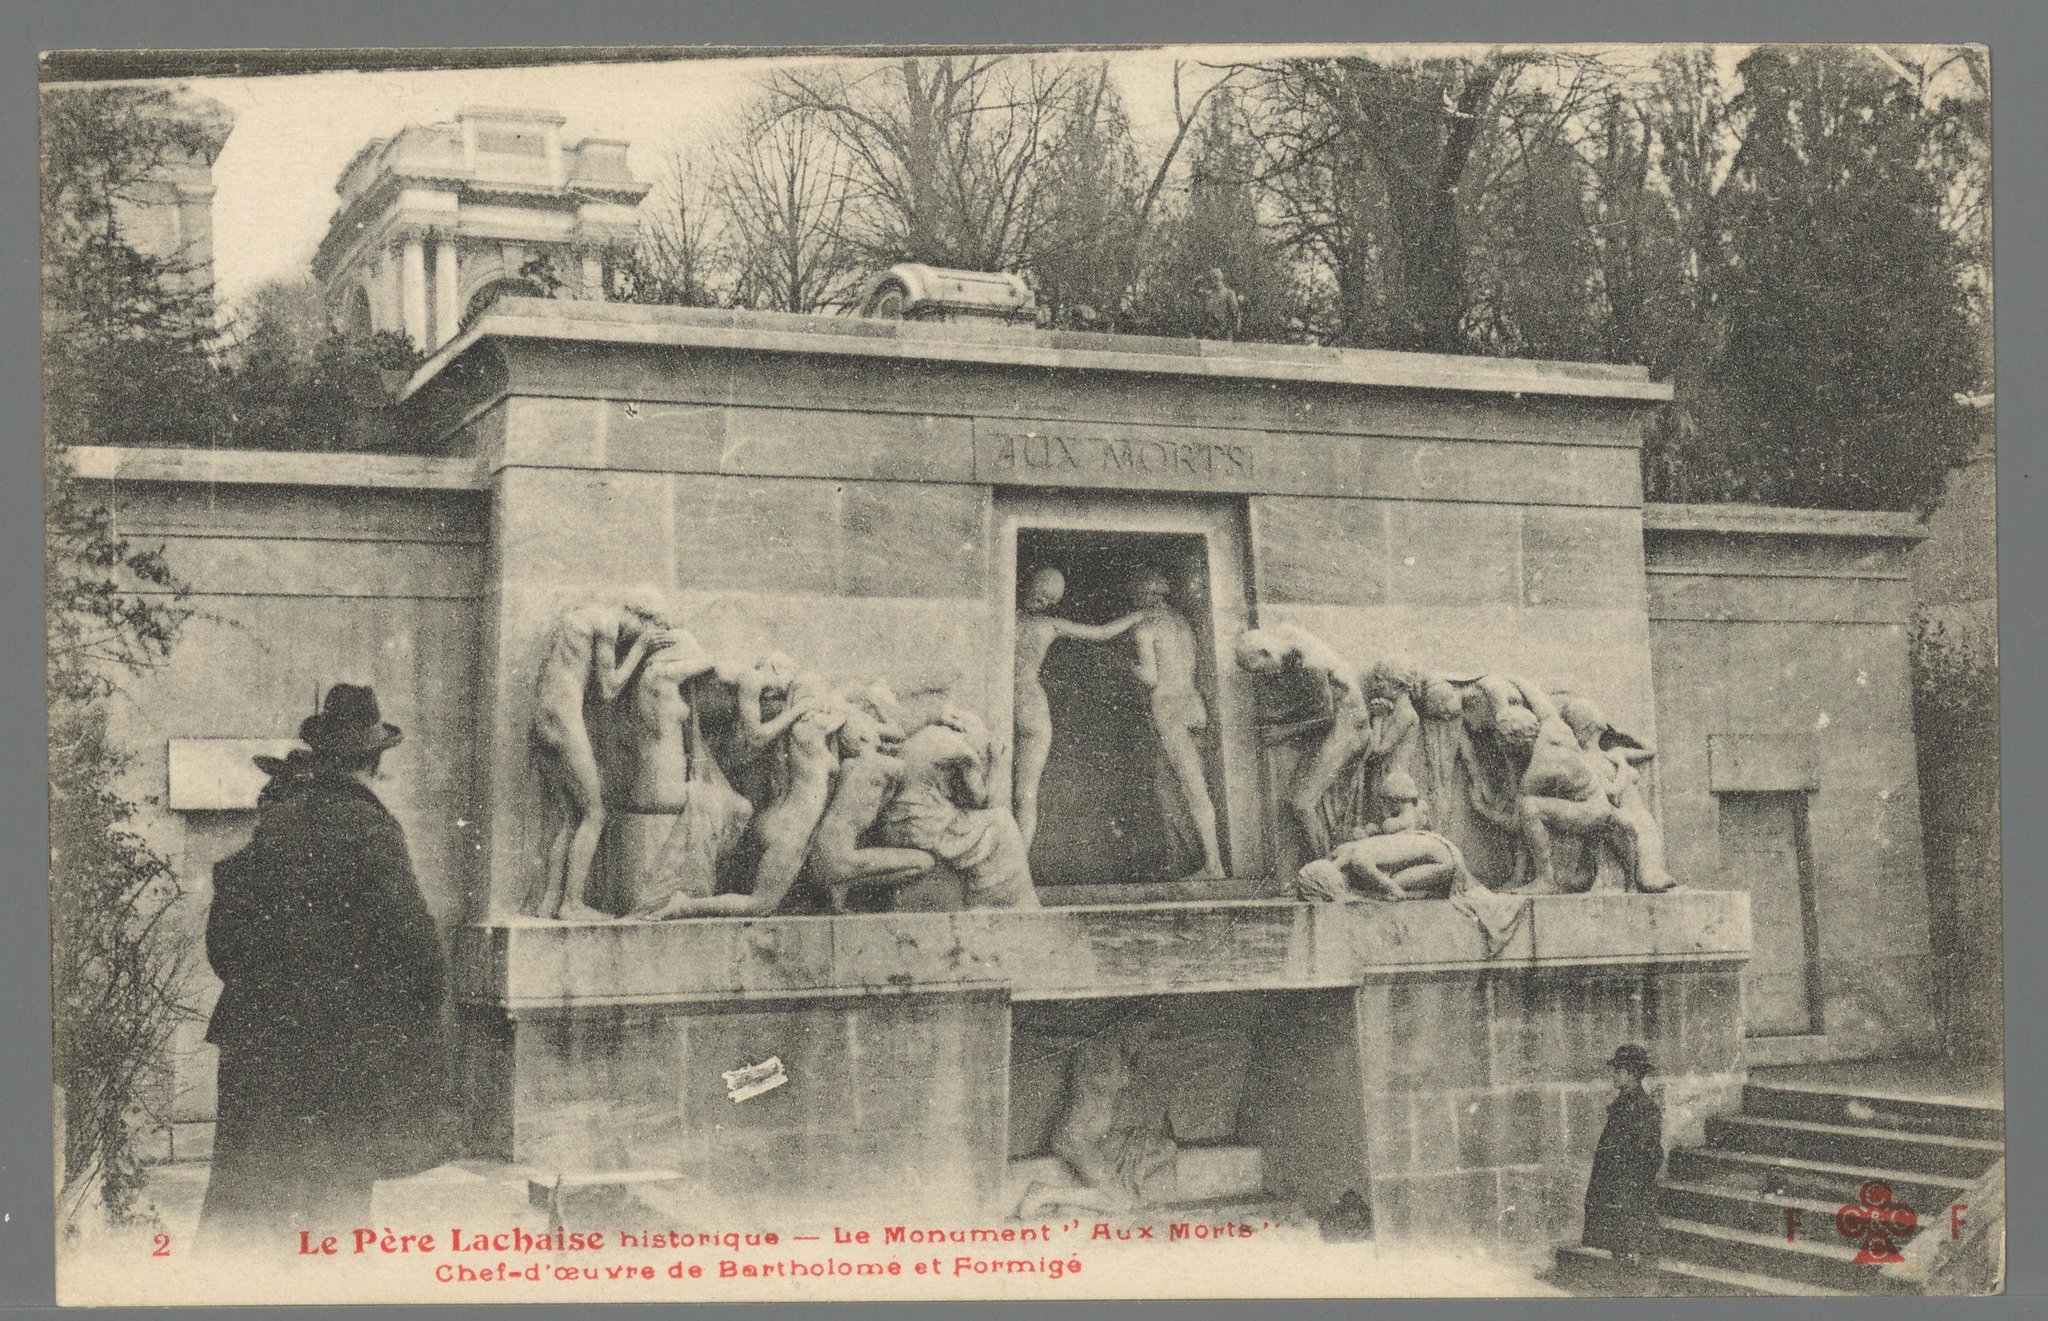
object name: ansichtkaart, prentbriefkaart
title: Le Père Lachaise historique. Le Monument "Aux Morts". Chef-d'oeuvre de Bartholomé et Formigé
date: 1904-1906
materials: cardboard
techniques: photograph, writing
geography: paris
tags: monument, statue, cemetery, park-like burying ground